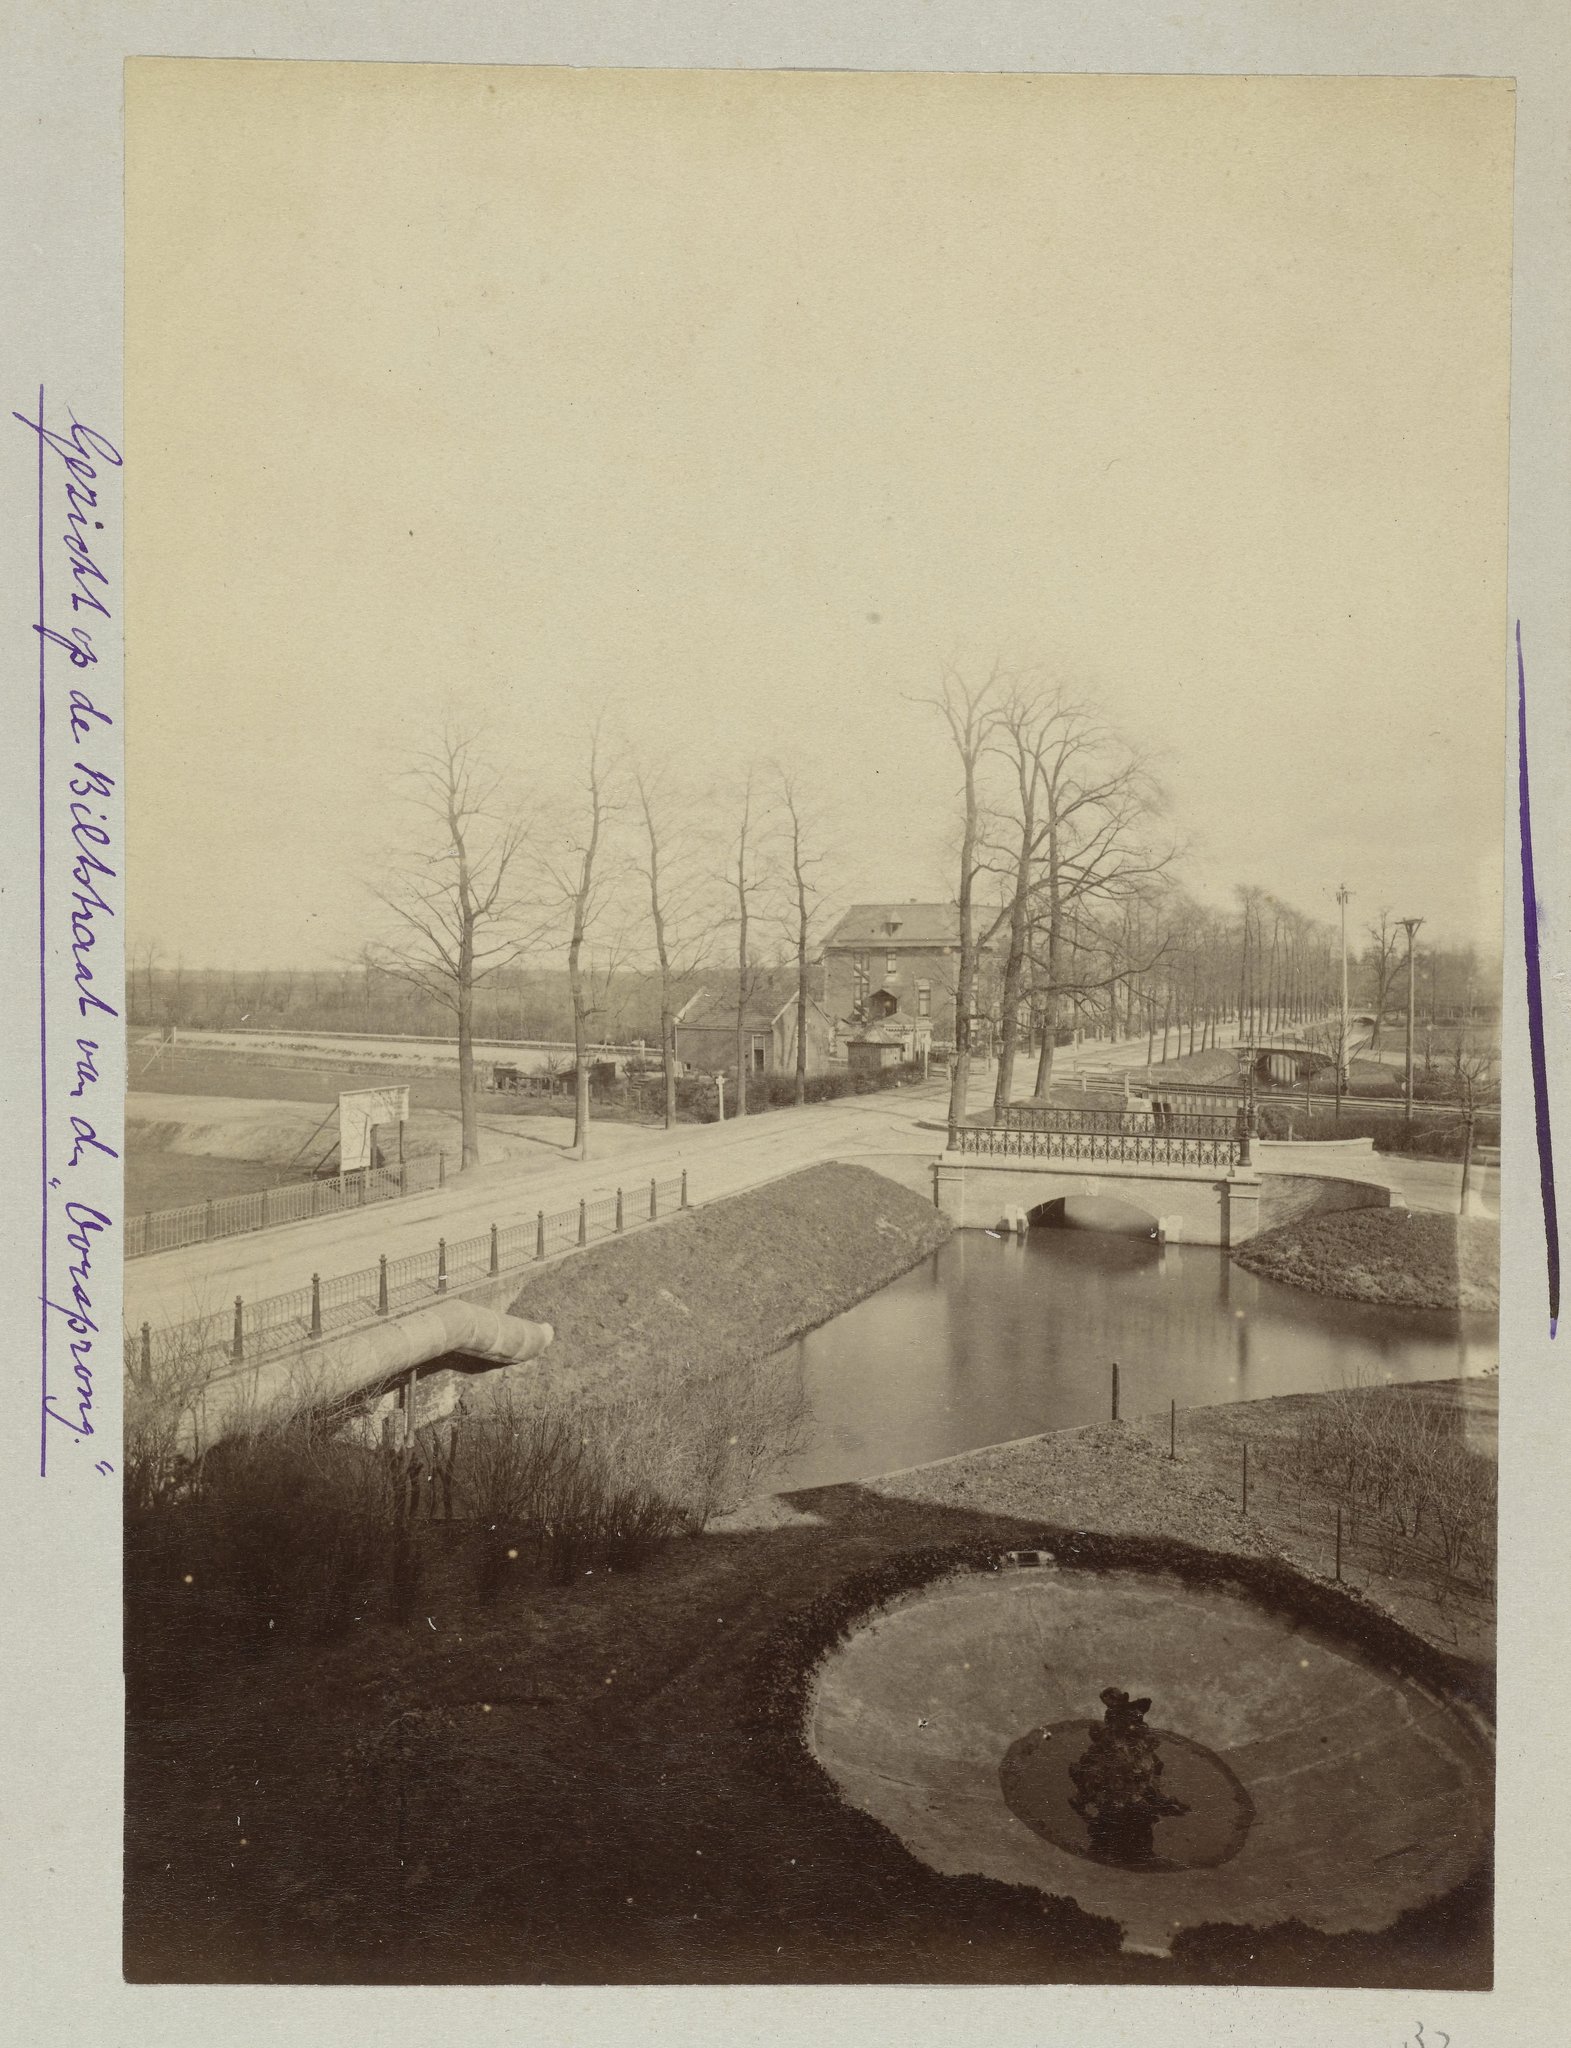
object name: photograph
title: Gezicht op de Biltstraat vanuit herenhuis De Oorsprong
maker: henry pauw van wieldrecht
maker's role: fotograaf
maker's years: 1863-1912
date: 1888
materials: paper, photographic support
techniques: albumen print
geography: netherlands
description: Zicht op de vrijwel onbebouwde Biltstraat vanuit Herenhuis De Oorsprong. Links op het albumblad geschreven: Gezicht op de Biltstraat van De Oorsprong.